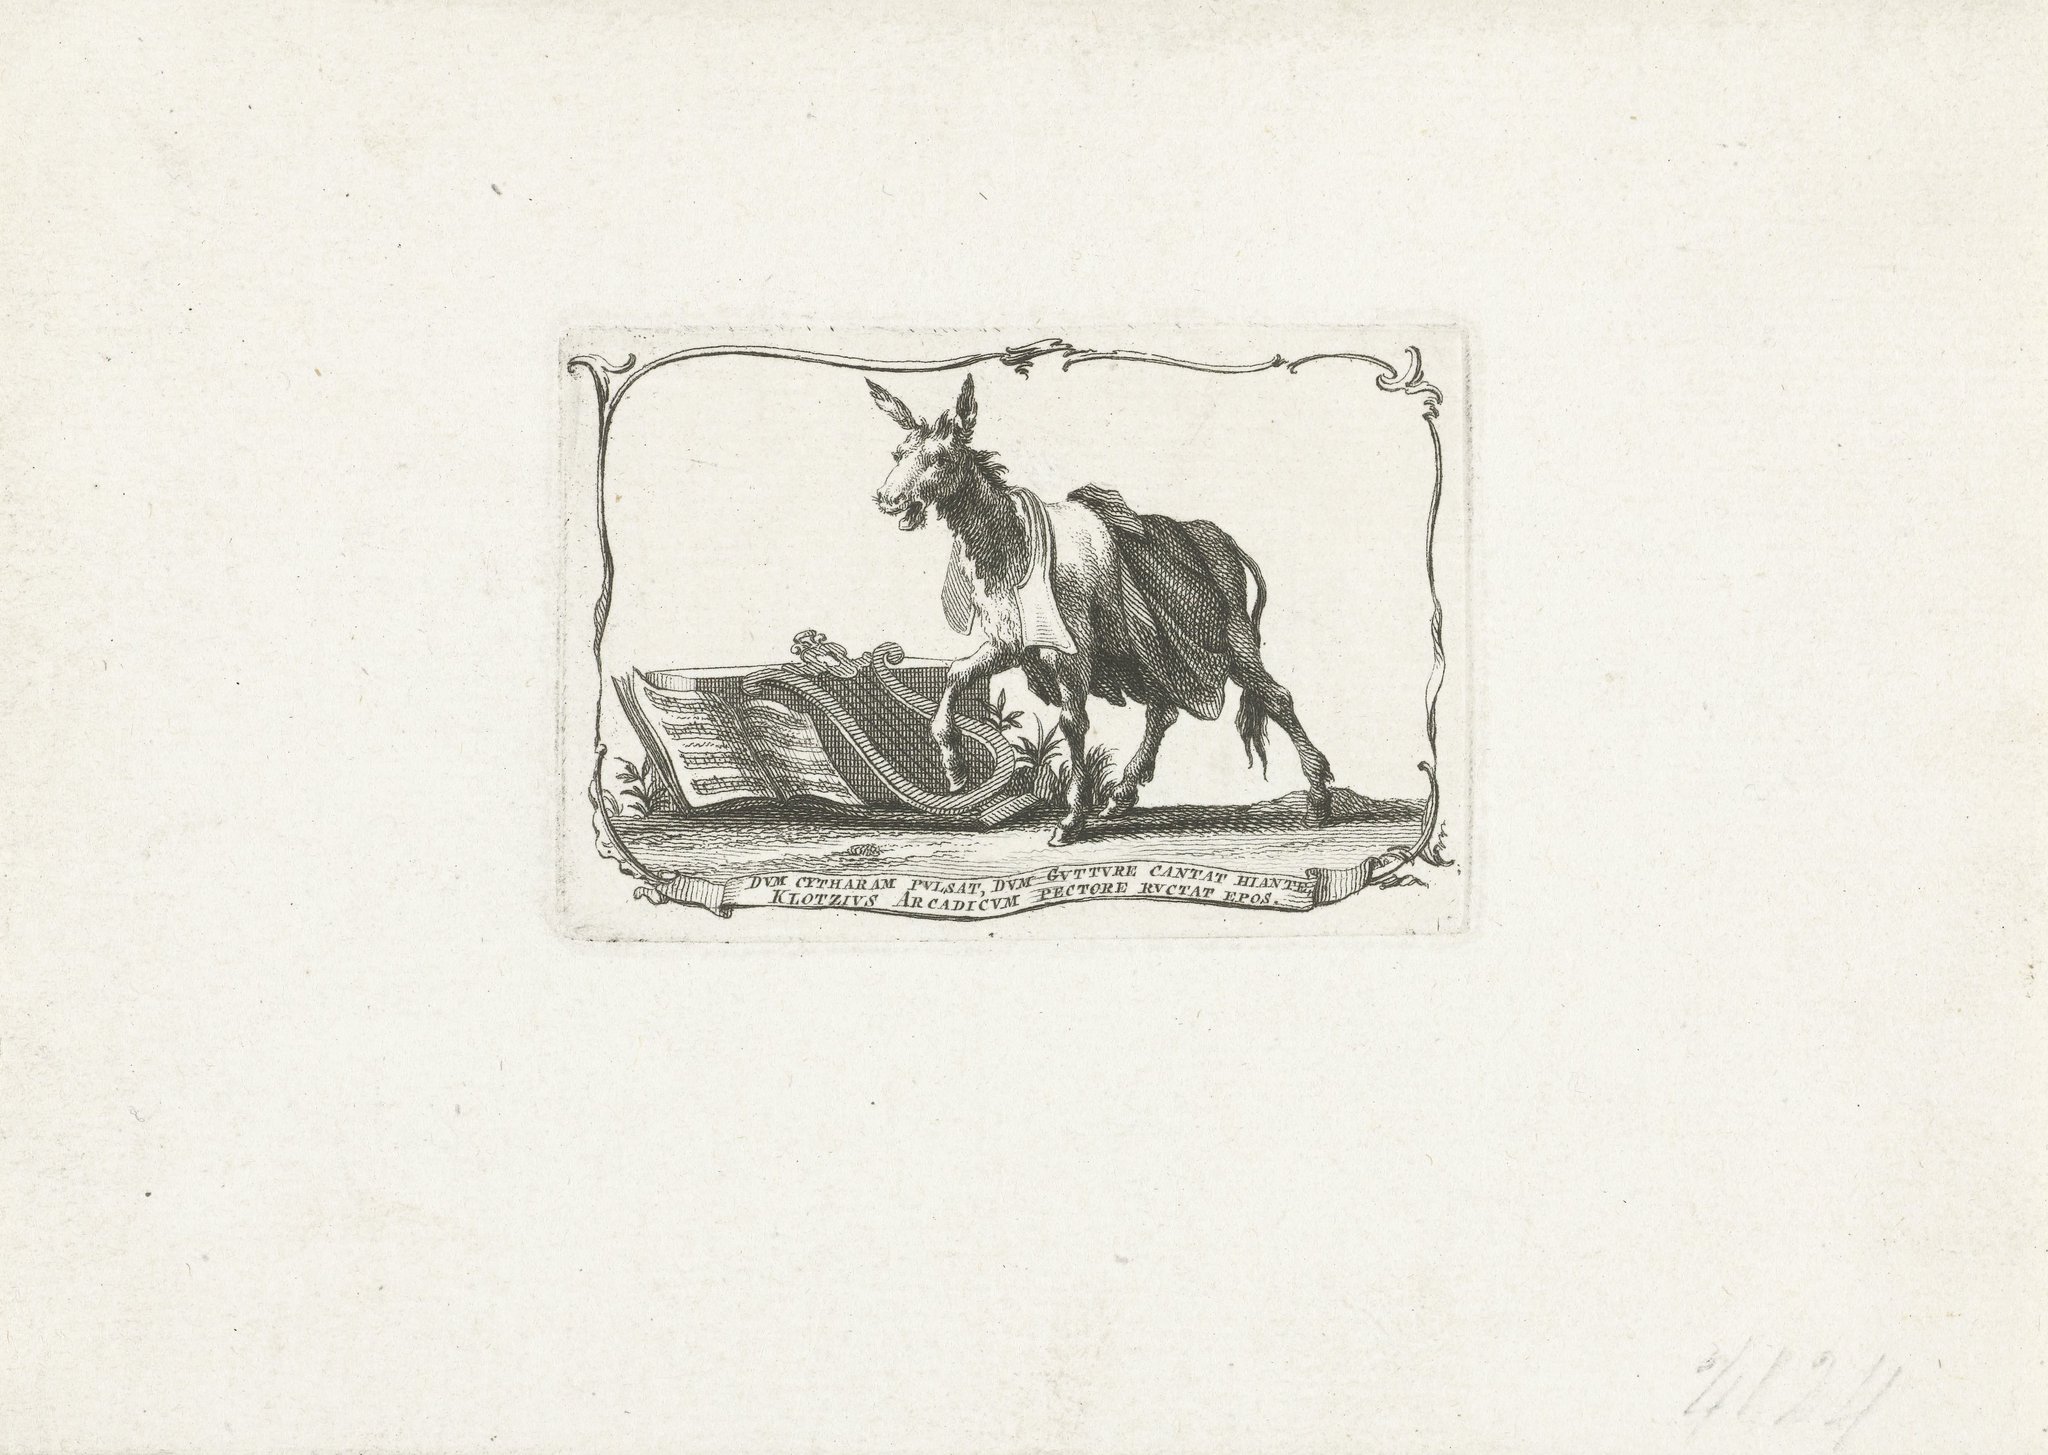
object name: print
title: Vignet met bespotting van C.A. Klotz, 1761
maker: jan punt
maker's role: draughtsman, print maker, publisher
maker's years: 1711-1779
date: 1762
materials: paper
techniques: engraving, etching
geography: northern netherlands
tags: ass, donkey, animals acting as human beings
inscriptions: collector's mark: Lugt 2228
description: Een ezel balkt en bespeelt met zijn poot een lier. Vignet waarin de spot wordt gedreven met de Duitse geleerde Christian Adolph Klotz.